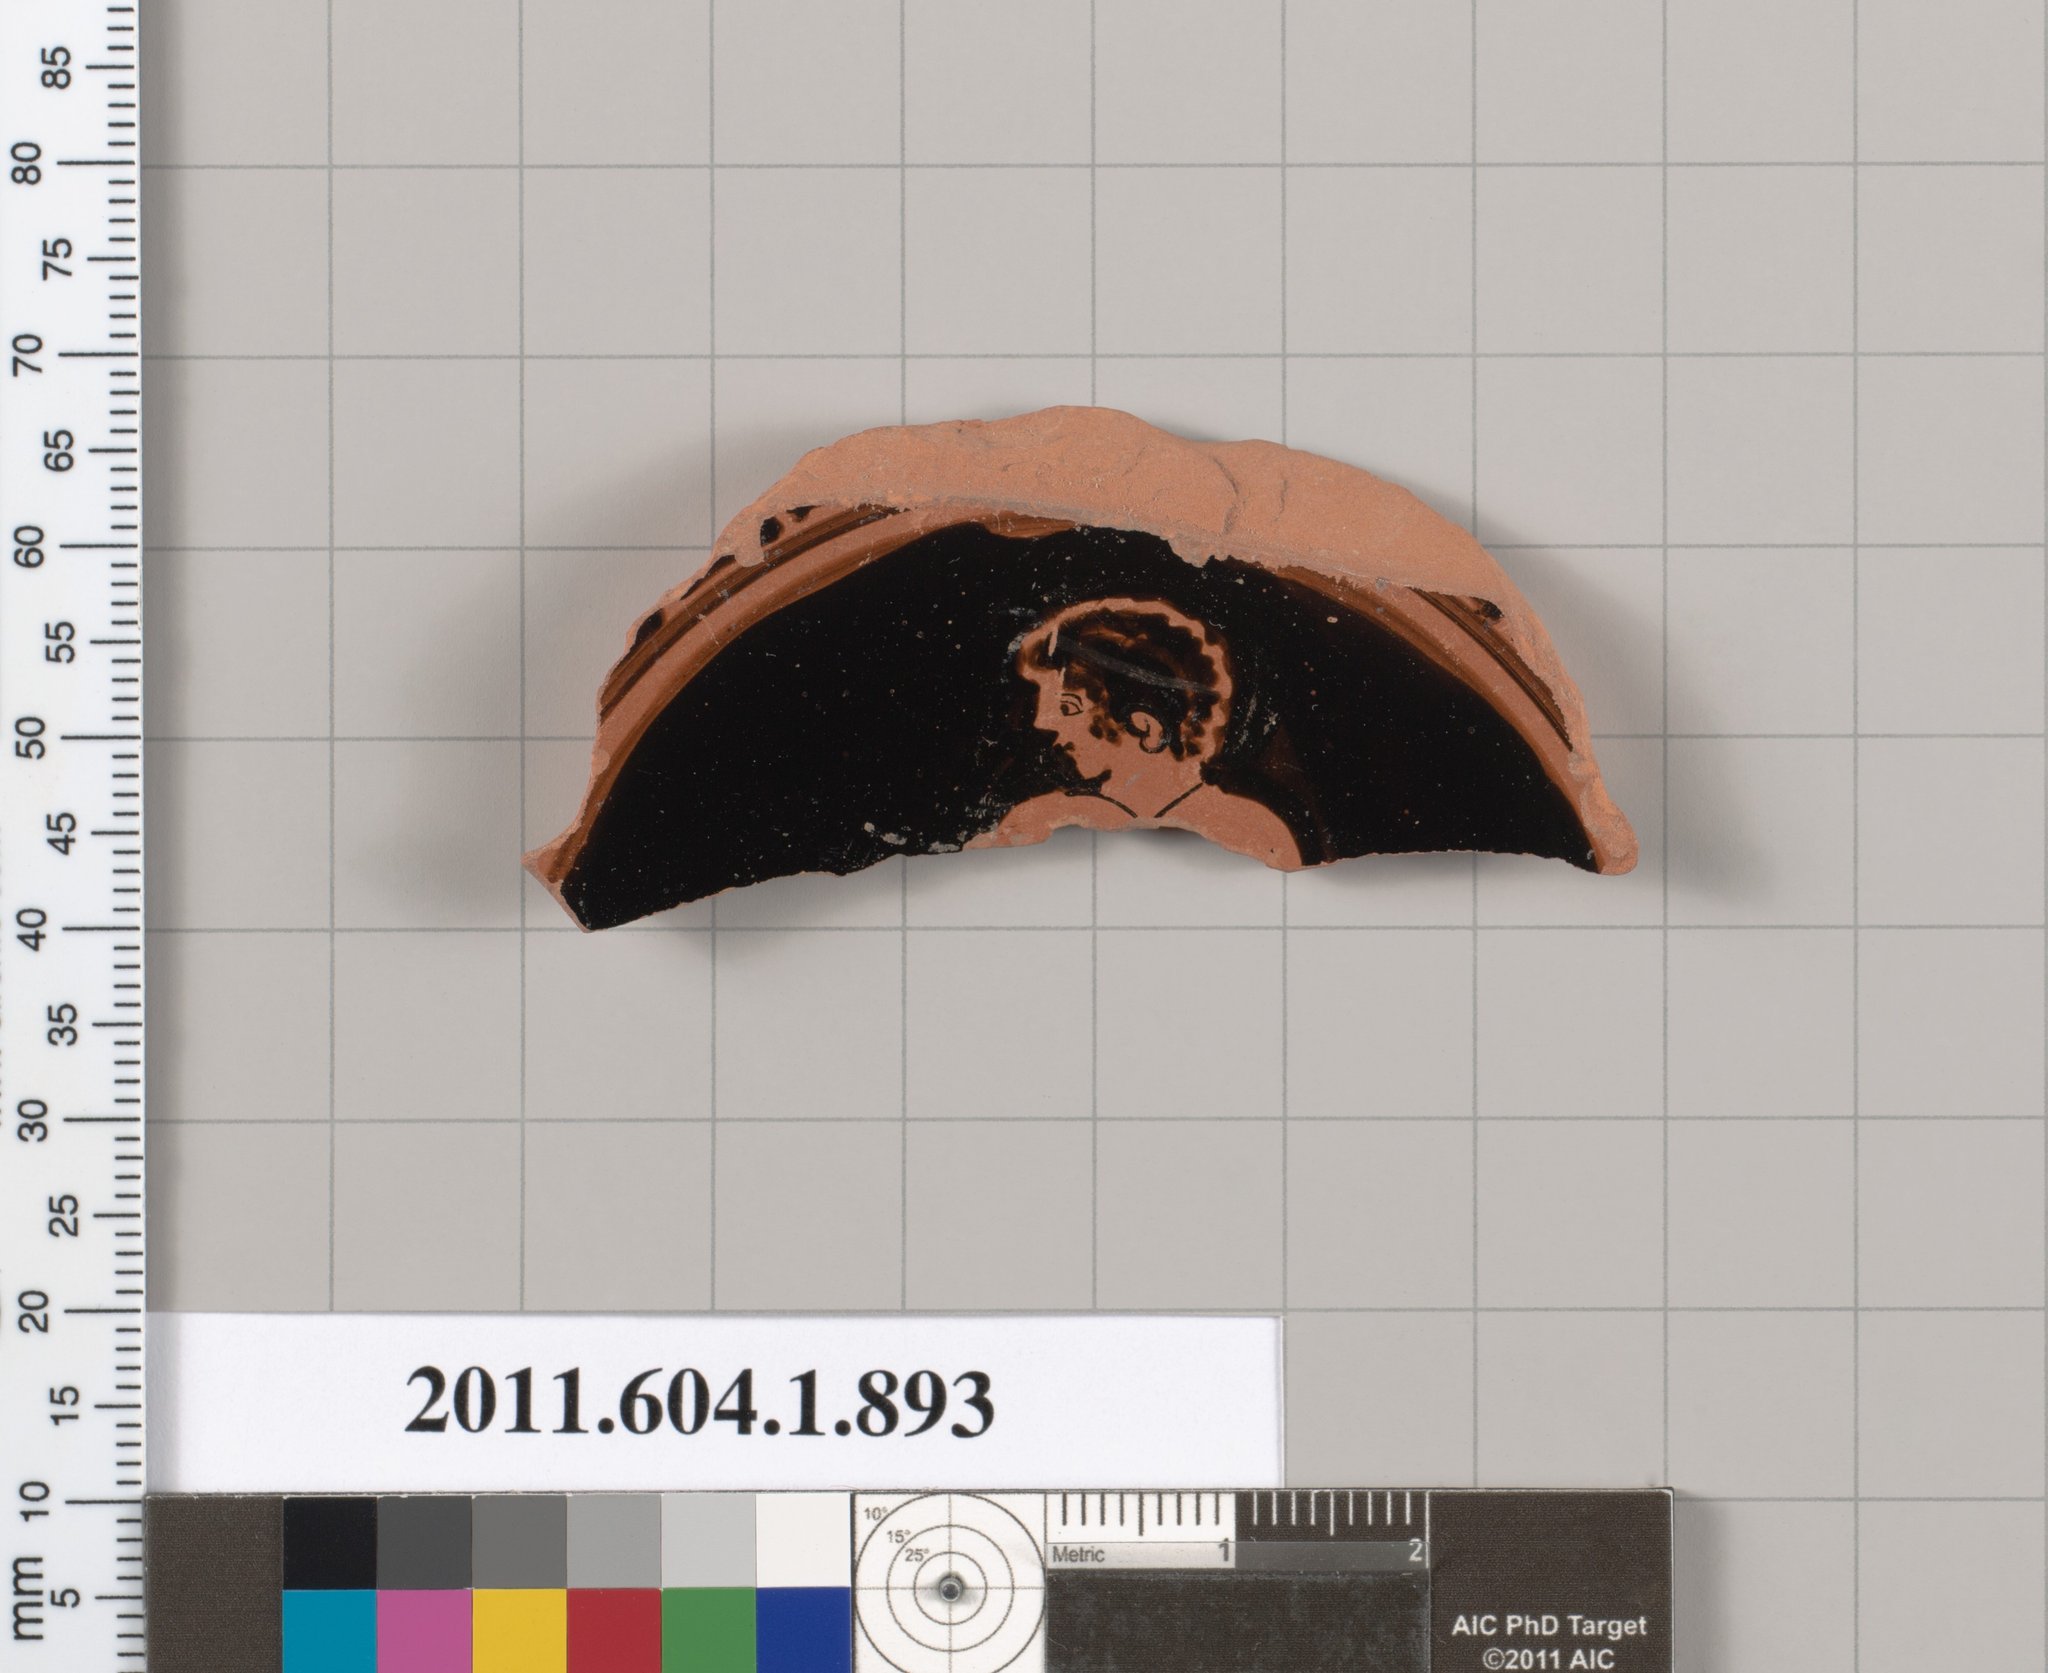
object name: kylix fragment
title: Terracotta fragment of a stemless cup (drinking cup)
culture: greek, attic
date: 467-435 BCE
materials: terracotta